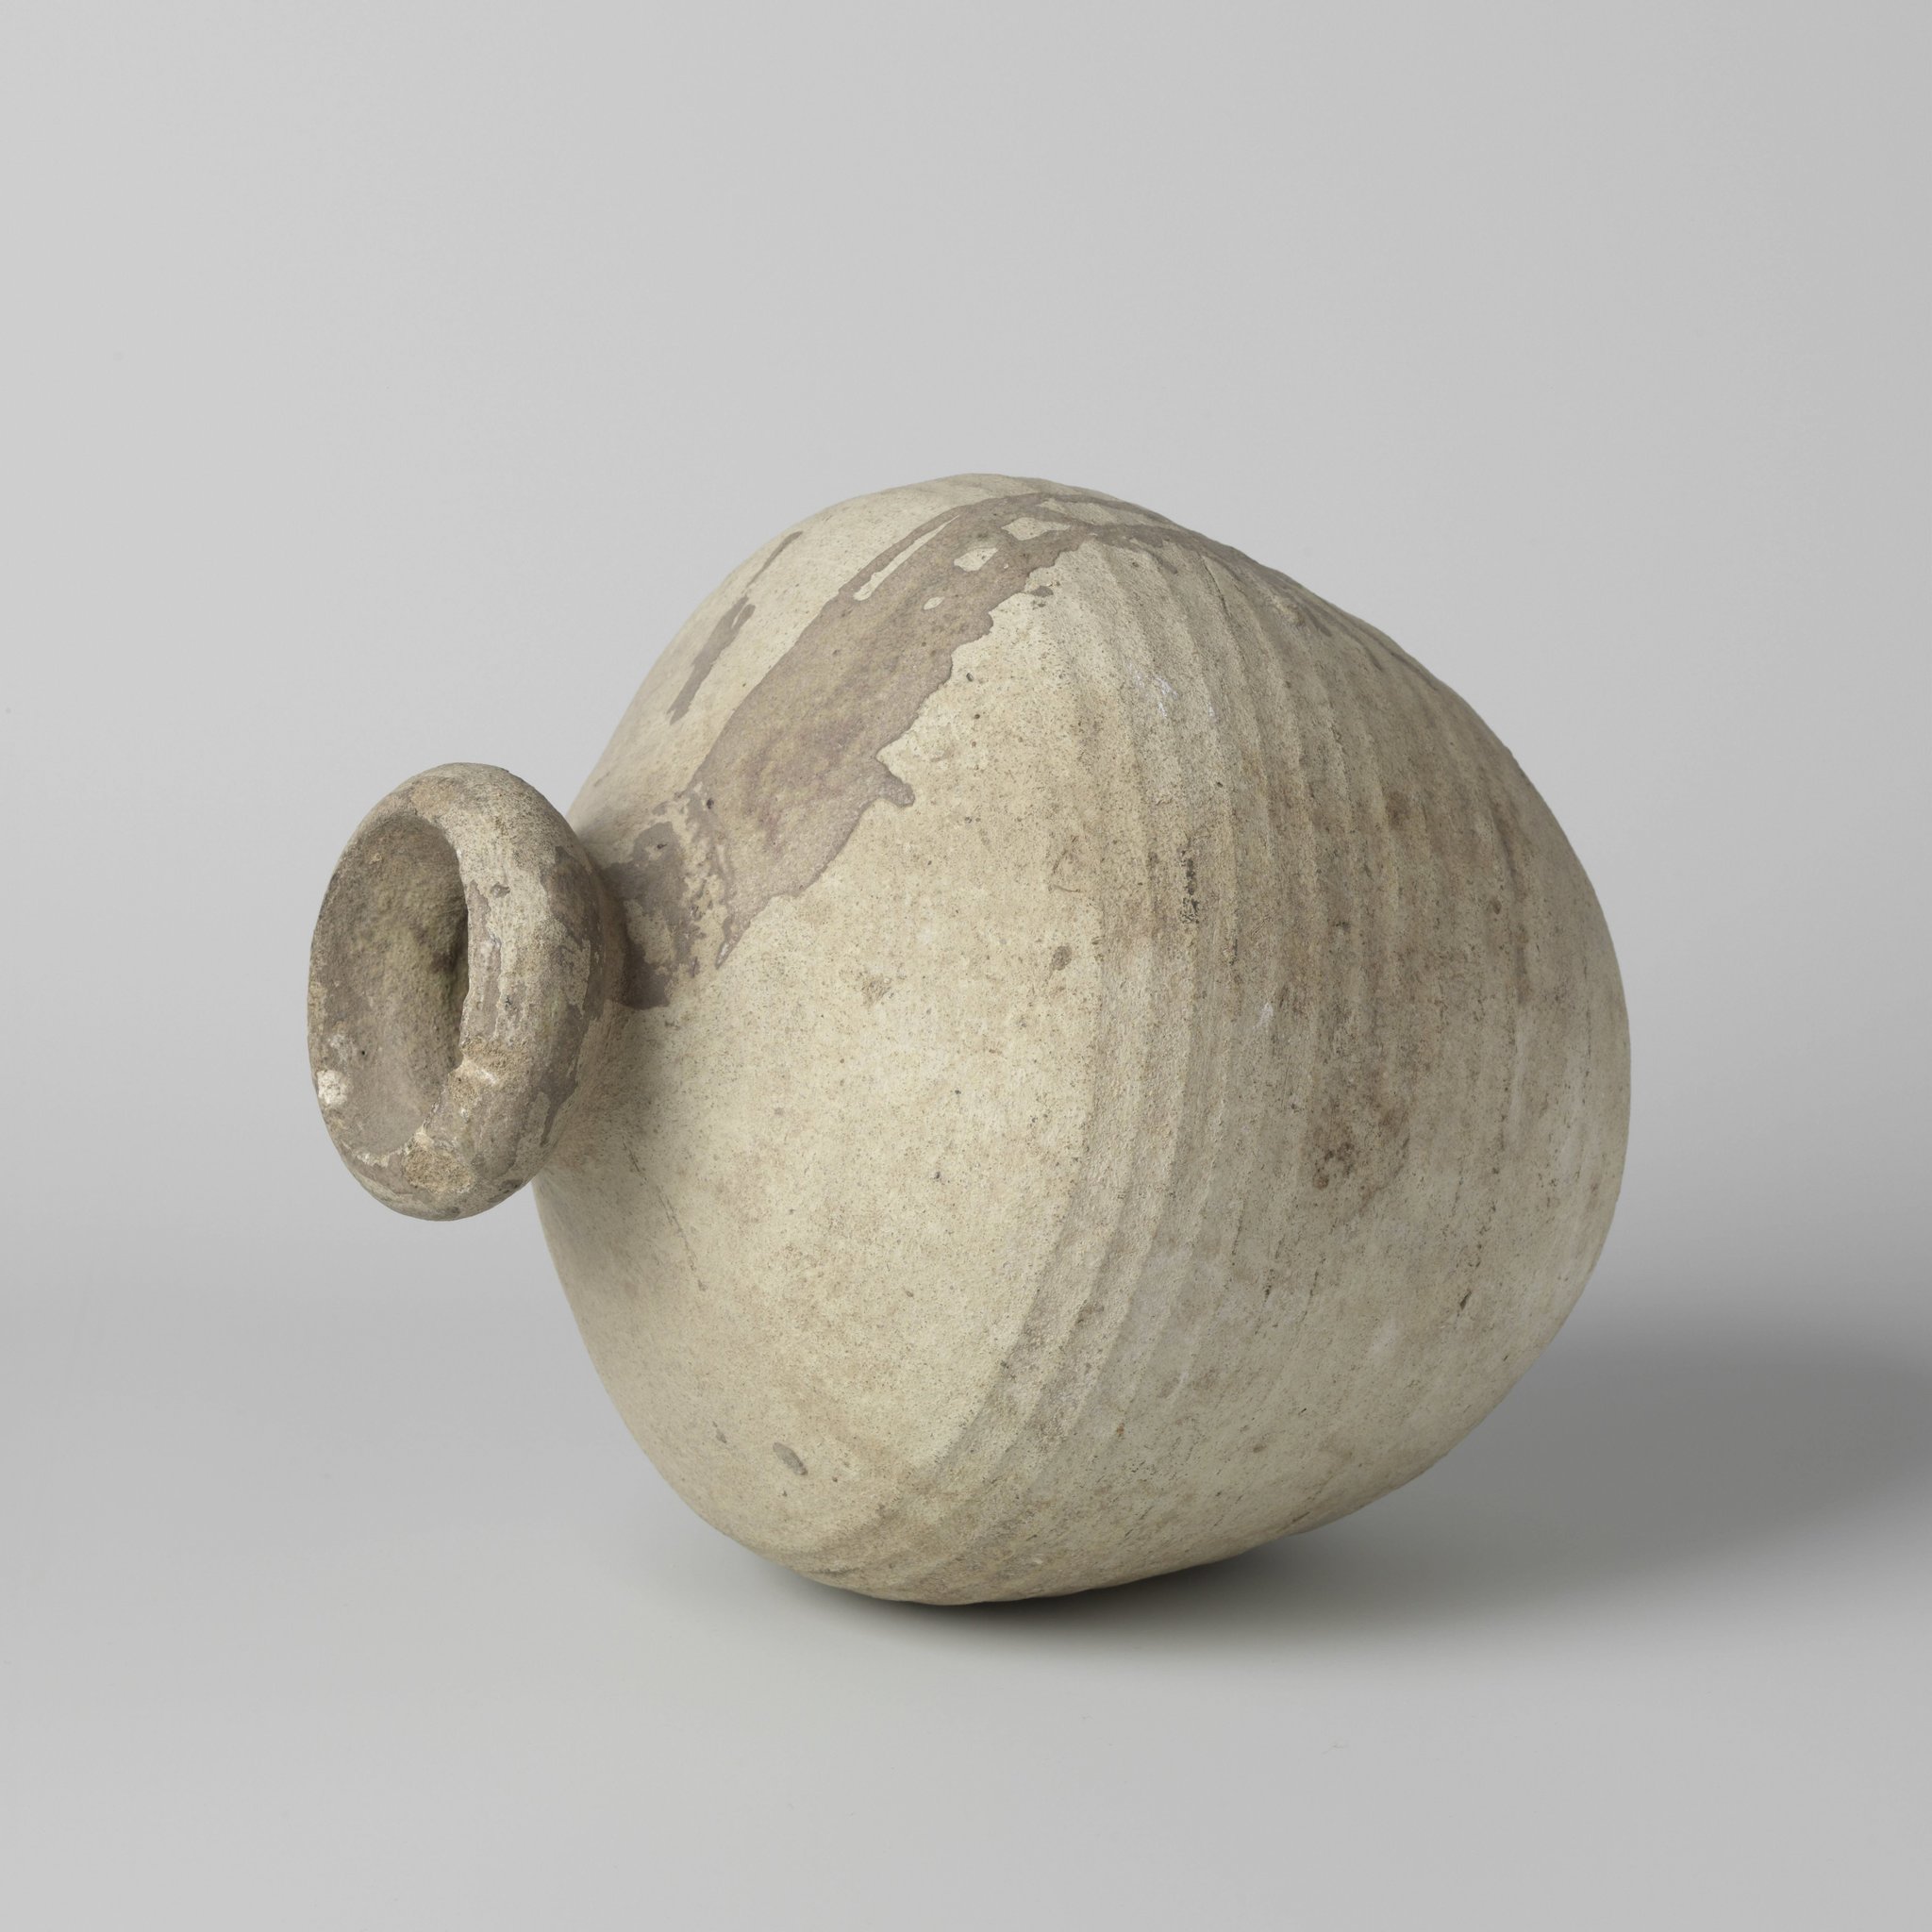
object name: jug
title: Kruik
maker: Anonymous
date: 1400-1950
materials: earthenware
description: Ronde kruik van aardewerk met verfresten. Pingsdorf?